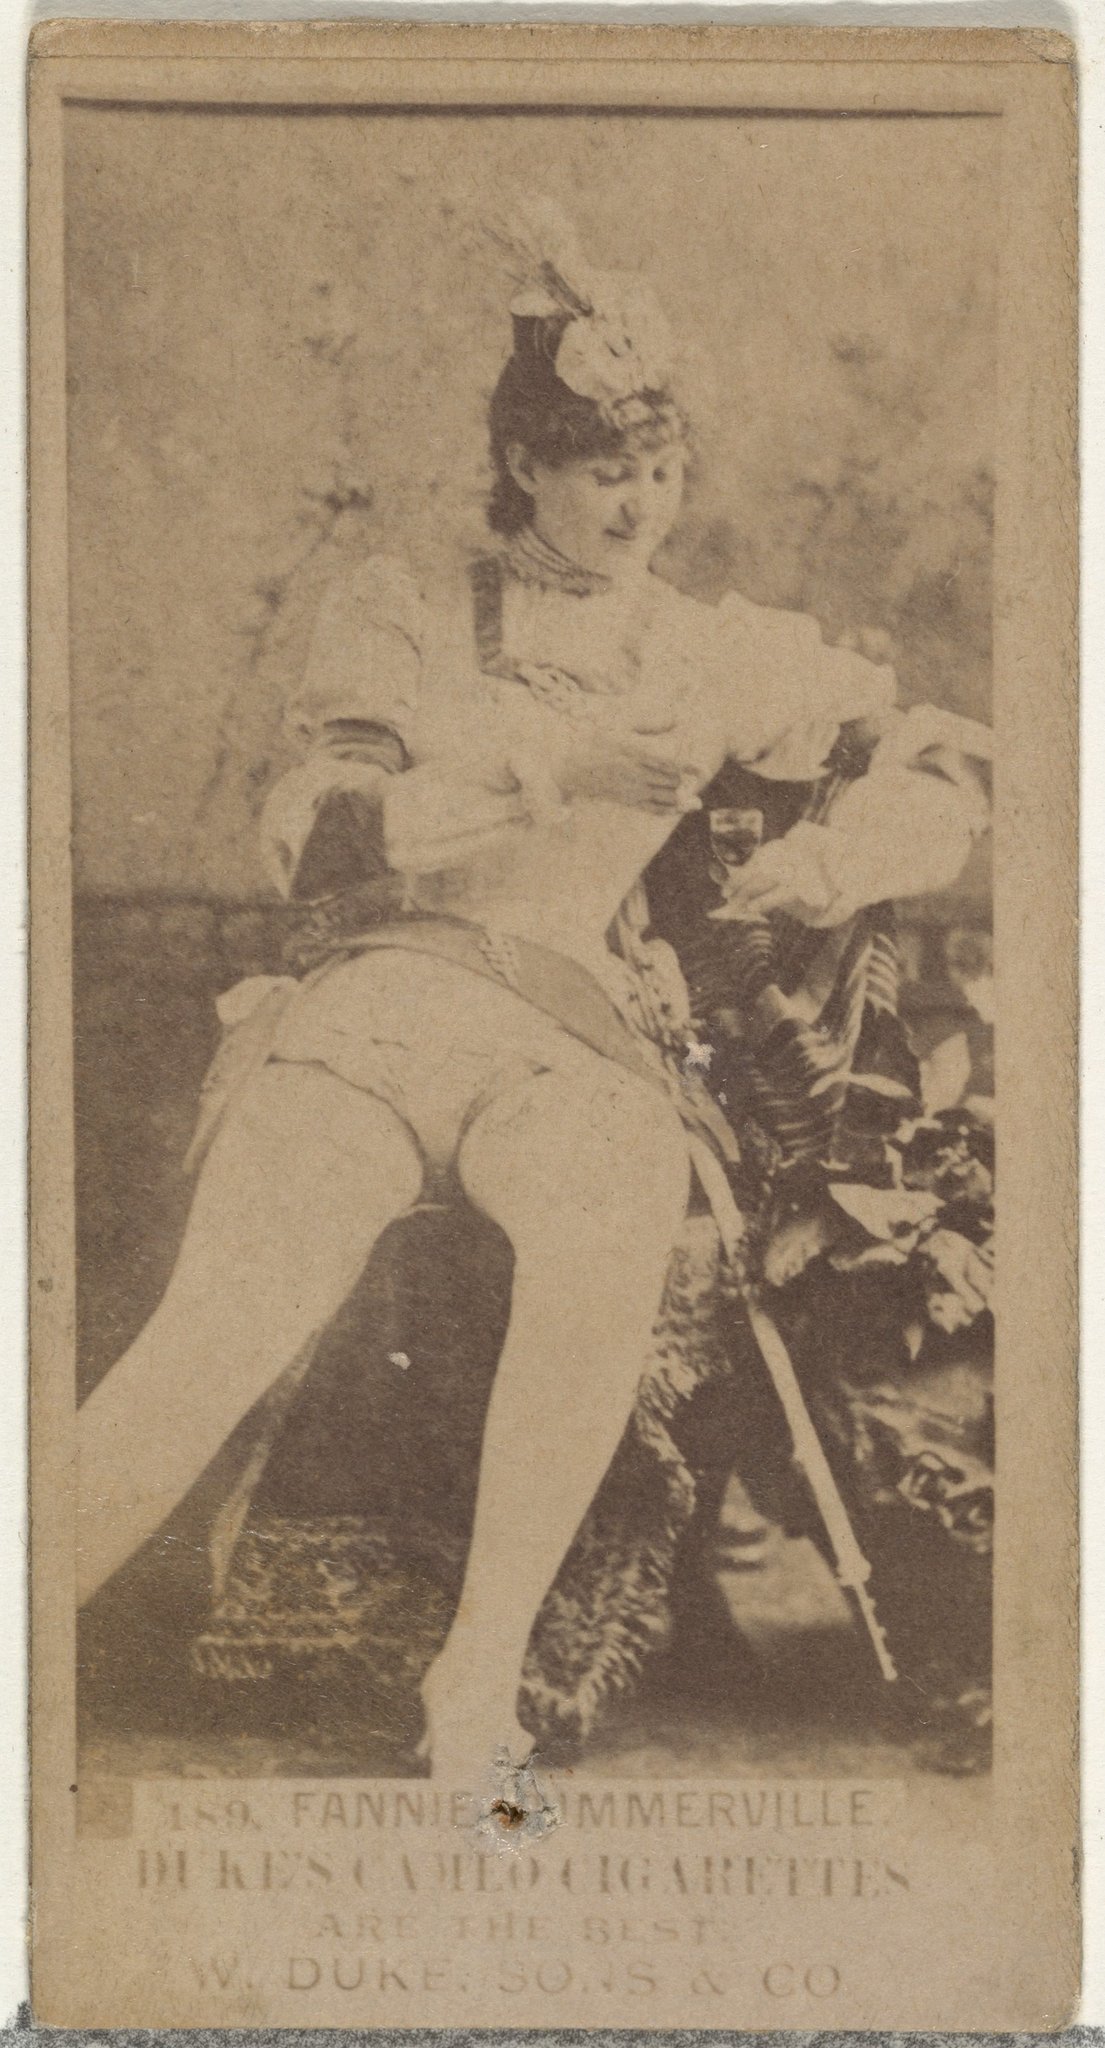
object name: photograph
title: Card Number 189, Fannie Summerville, from the Actors and Actresses series (N145-5) issued by Duke Sons & Co. to promote Cameo Cigarettes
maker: w. duke, sons & co.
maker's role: publisher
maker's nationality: american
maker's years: 1870-1920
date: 1880-1889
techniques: albumen silver print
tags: portraits,women,actresses